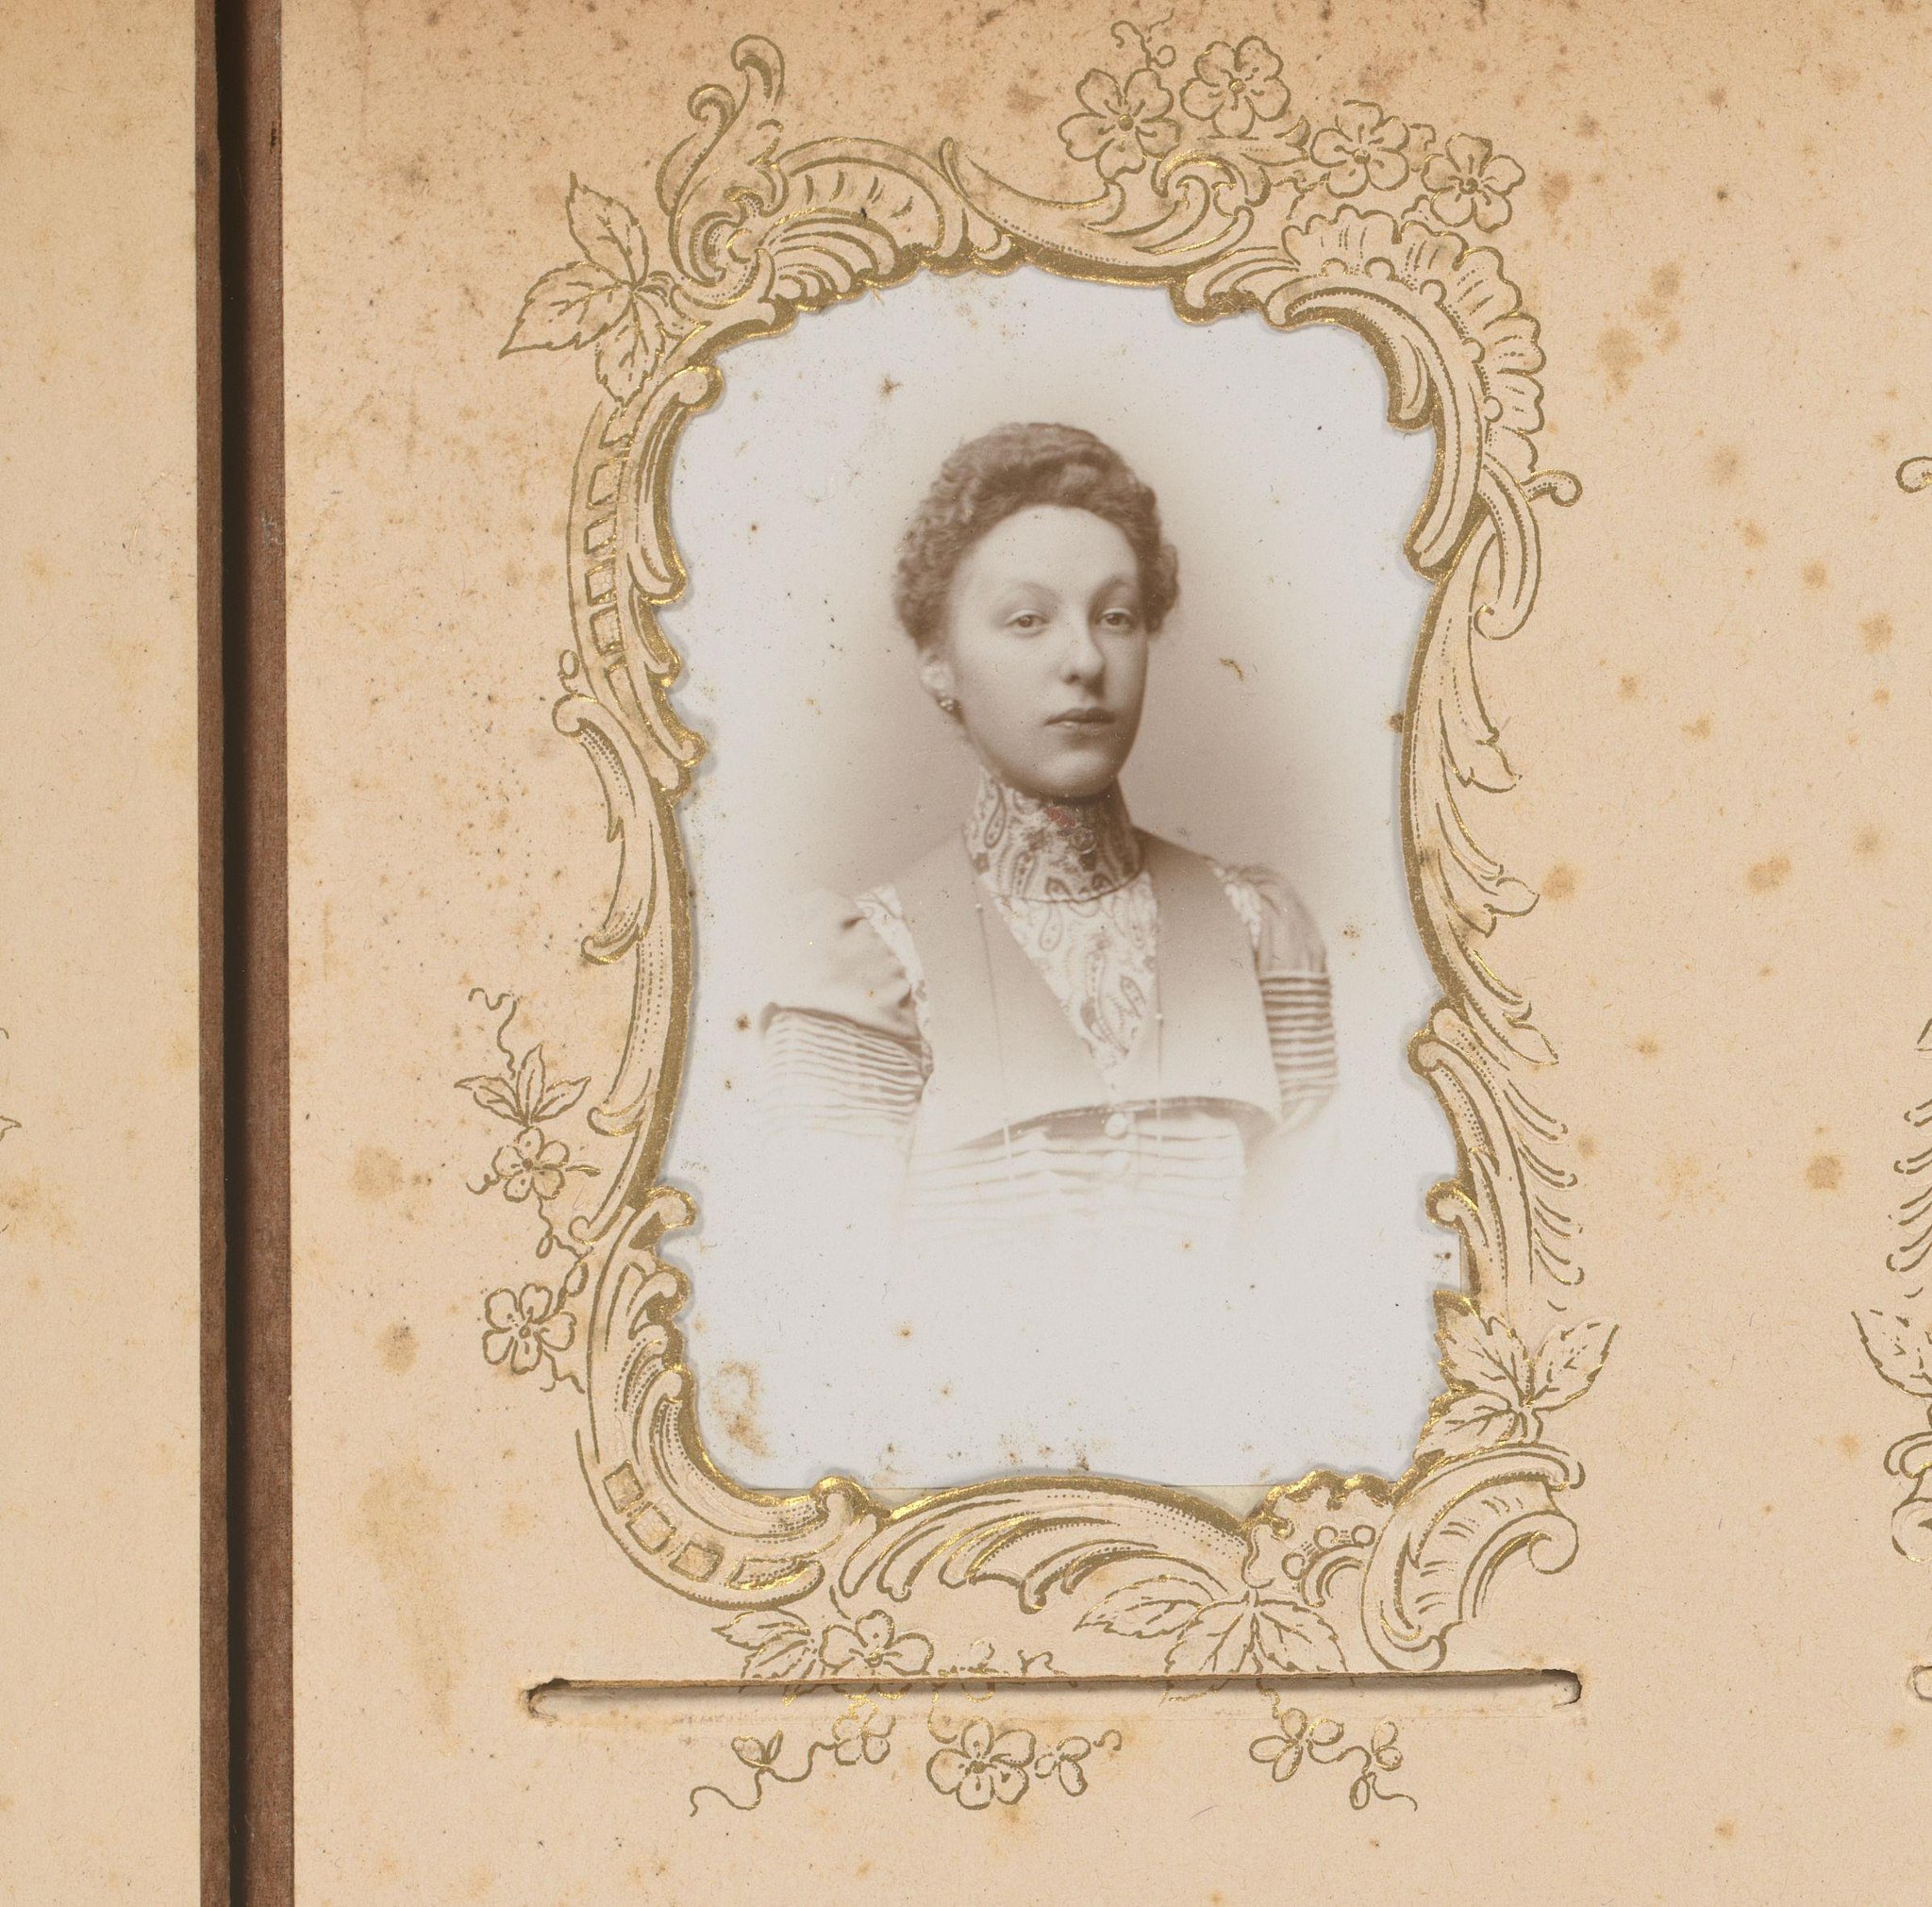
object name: carte de visite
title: Portret van een jonge vrouw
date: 1885-1906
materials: cardboard, photographic support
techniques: collodion silver print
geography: amsterdam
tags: adolescent, young woman, maiden, historical persons - bb - woman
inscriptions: inscription: ‘W.G. Kuijer & Zonen/ Amsterdam/ hofphotographen’